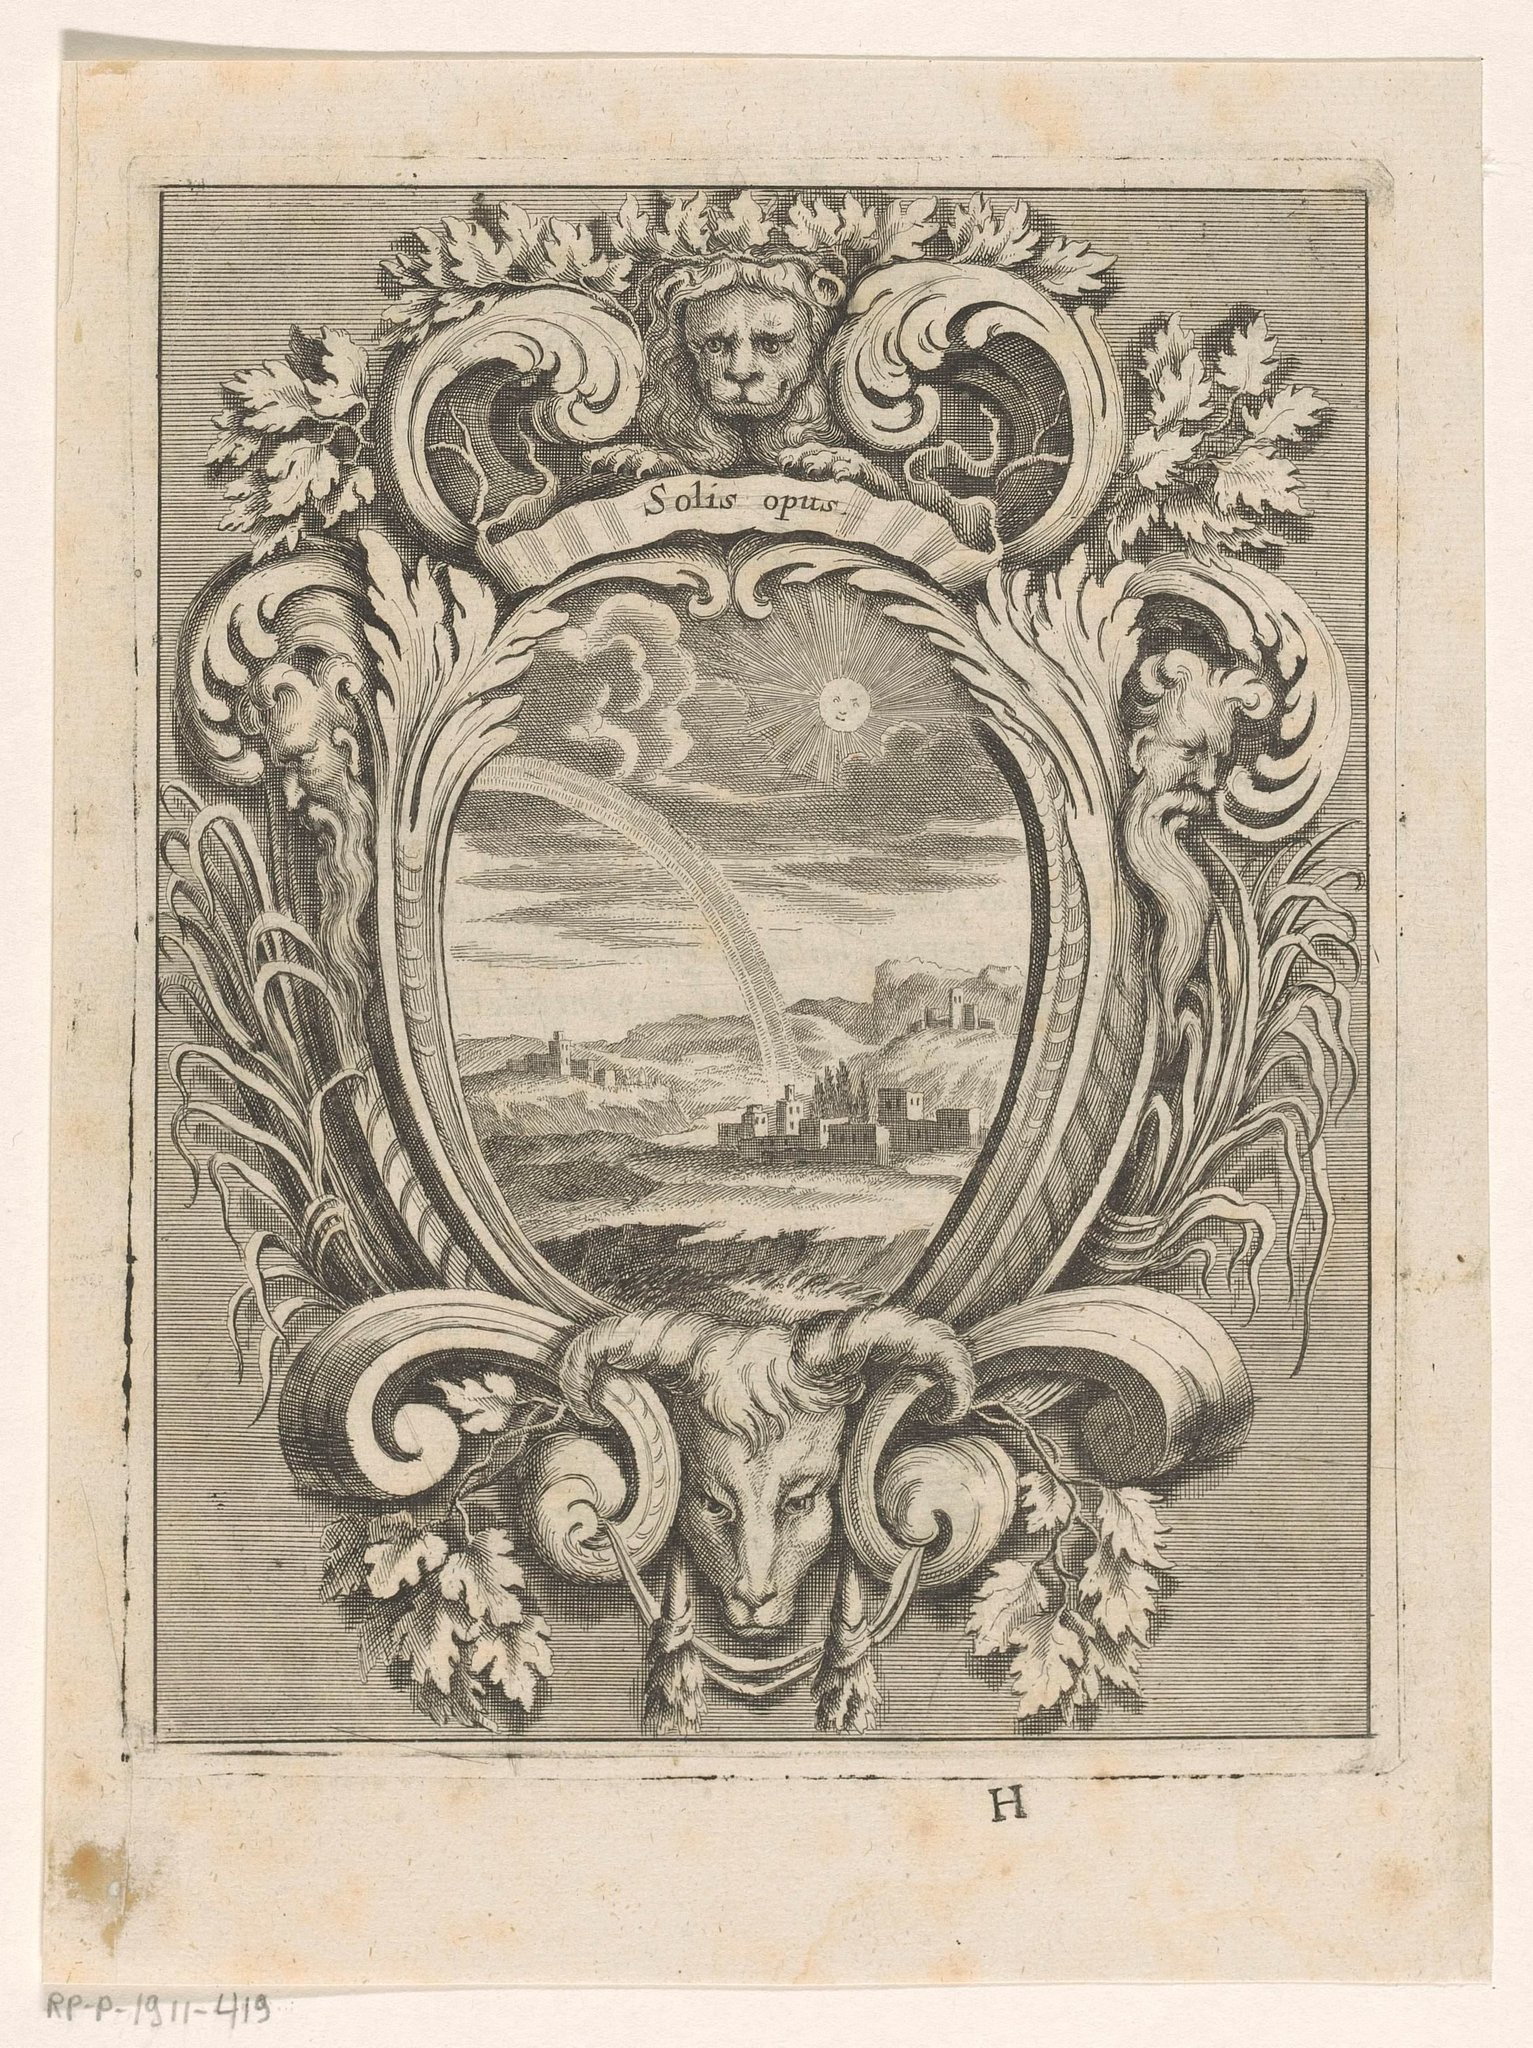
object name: print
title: Pars posterior symbolica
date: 1695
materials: paper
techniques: etching, letterpress printing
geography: sankt gallen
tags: city-view in general; 'veduta', sun represented as face, wheel, etc., abstract ideas and concepts (+ emblematical representation of concept), rainbow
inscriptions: collector's mark: Lugt 2228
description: Prent gebruikt voor: Sfondrati, Celestino. Innocentia vindicata in qua gravissimis argumentis ex S. Thoma petitis ostenditur. Sankt Gallen: Jacobus Müller, 1695.